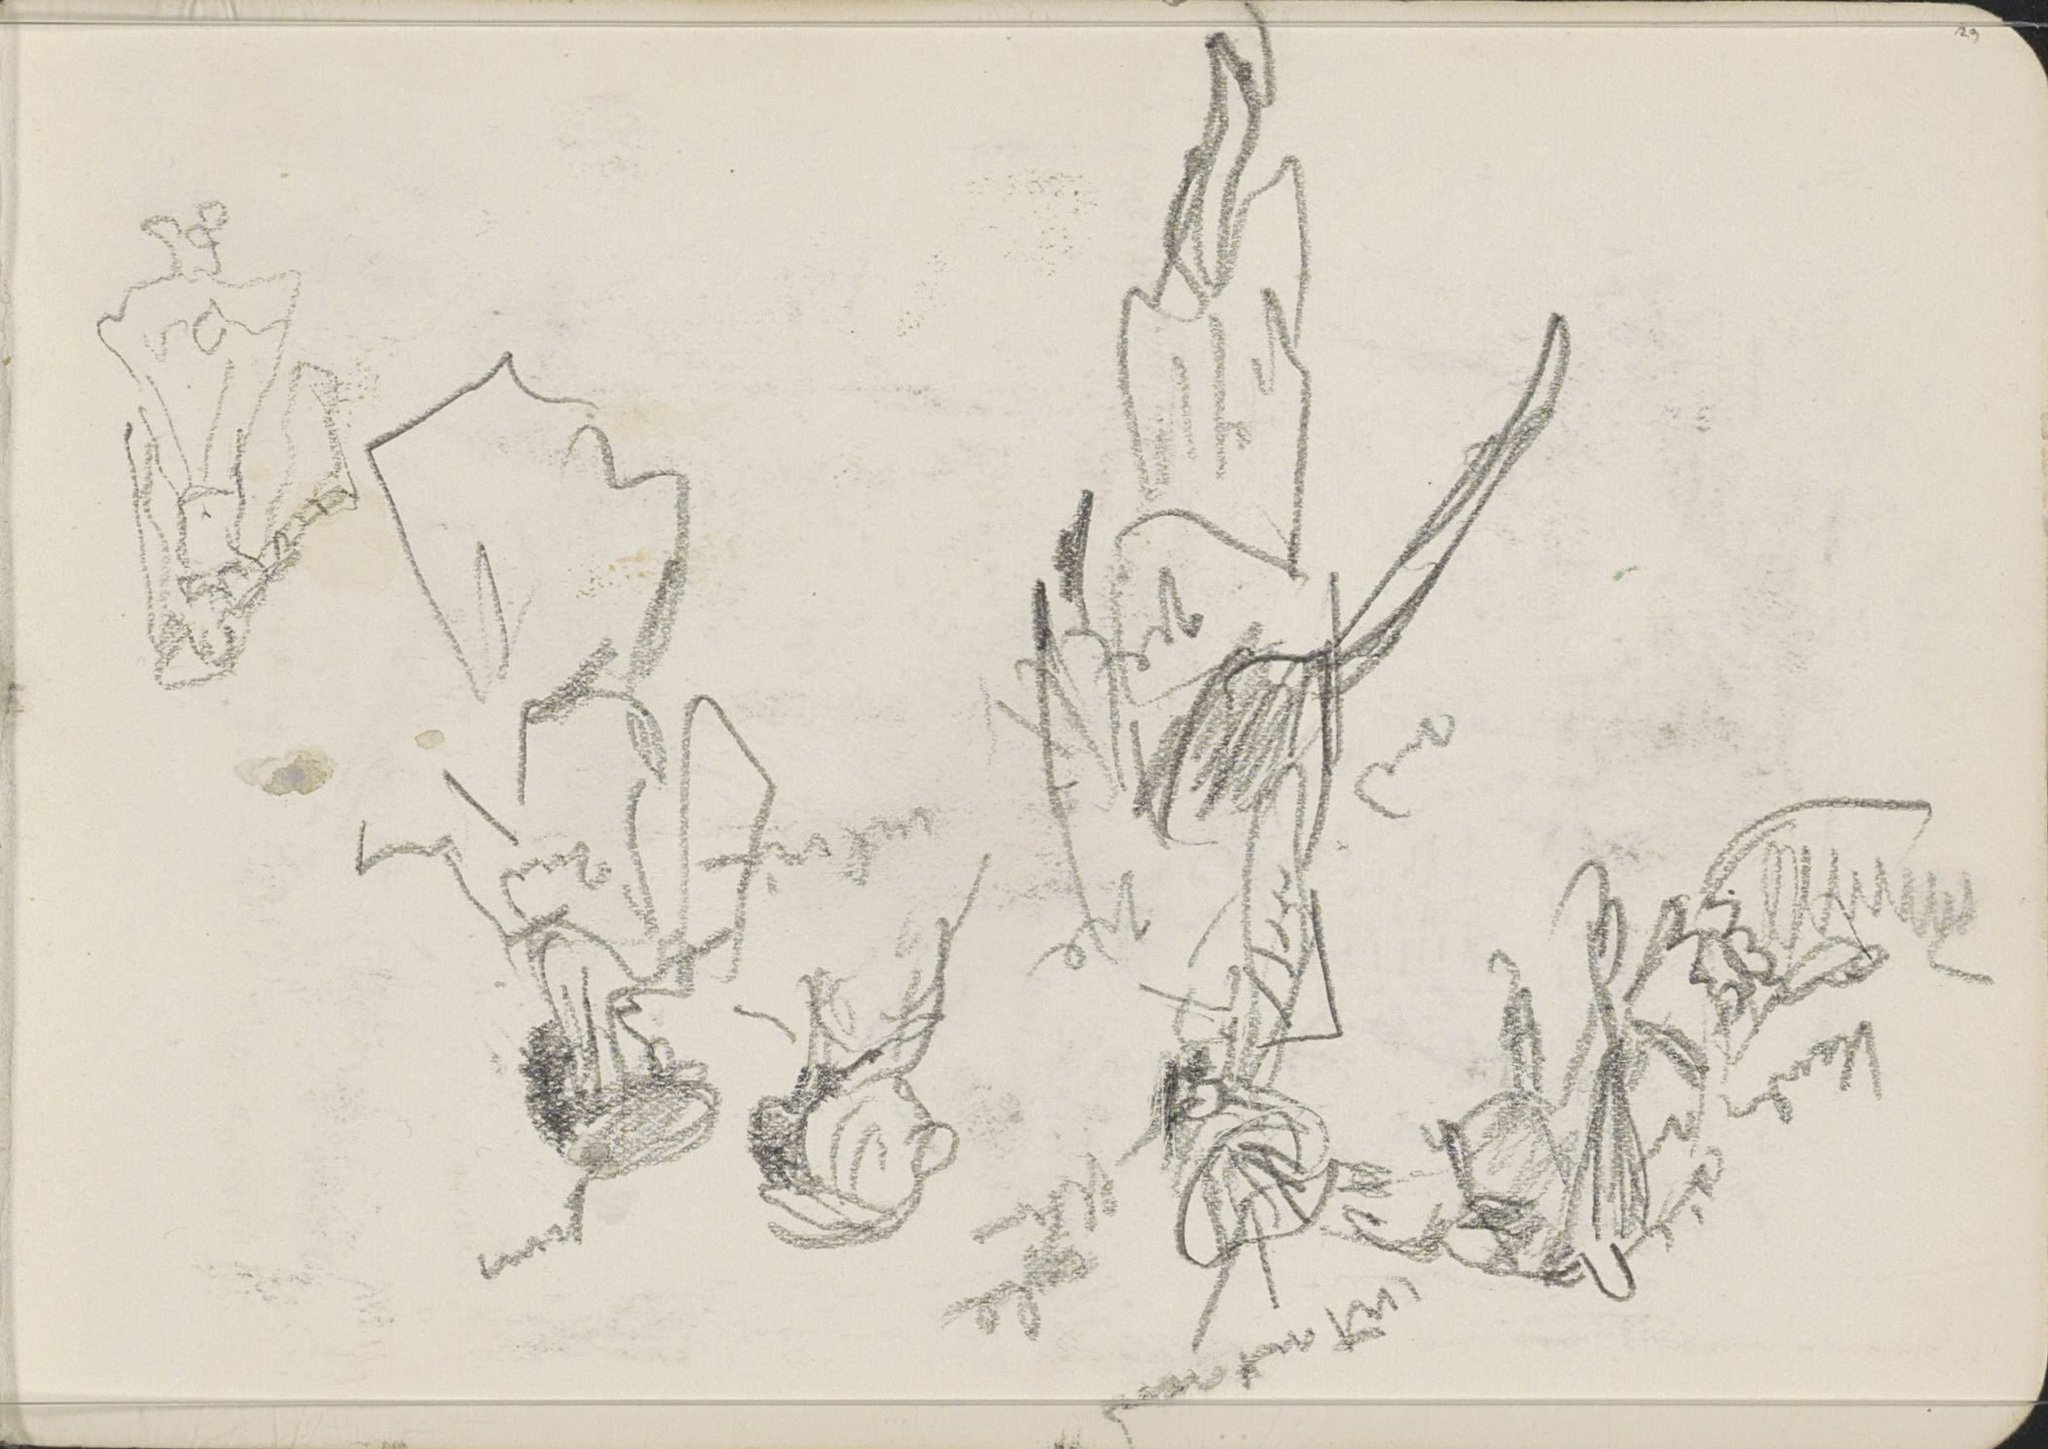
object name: sketchbook leaf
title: Indiërs en een kop van een kameel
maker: marius bauer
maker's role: draughtsman, print maker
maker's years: 1867-1932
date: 1925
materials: paper, pencil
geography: india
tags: hoofed animals: camel, asiatic races and peoples: indians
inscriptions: kleurnotitie, handgeschreven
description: Pagina 29 uit een schetsboek met 15 bladen.